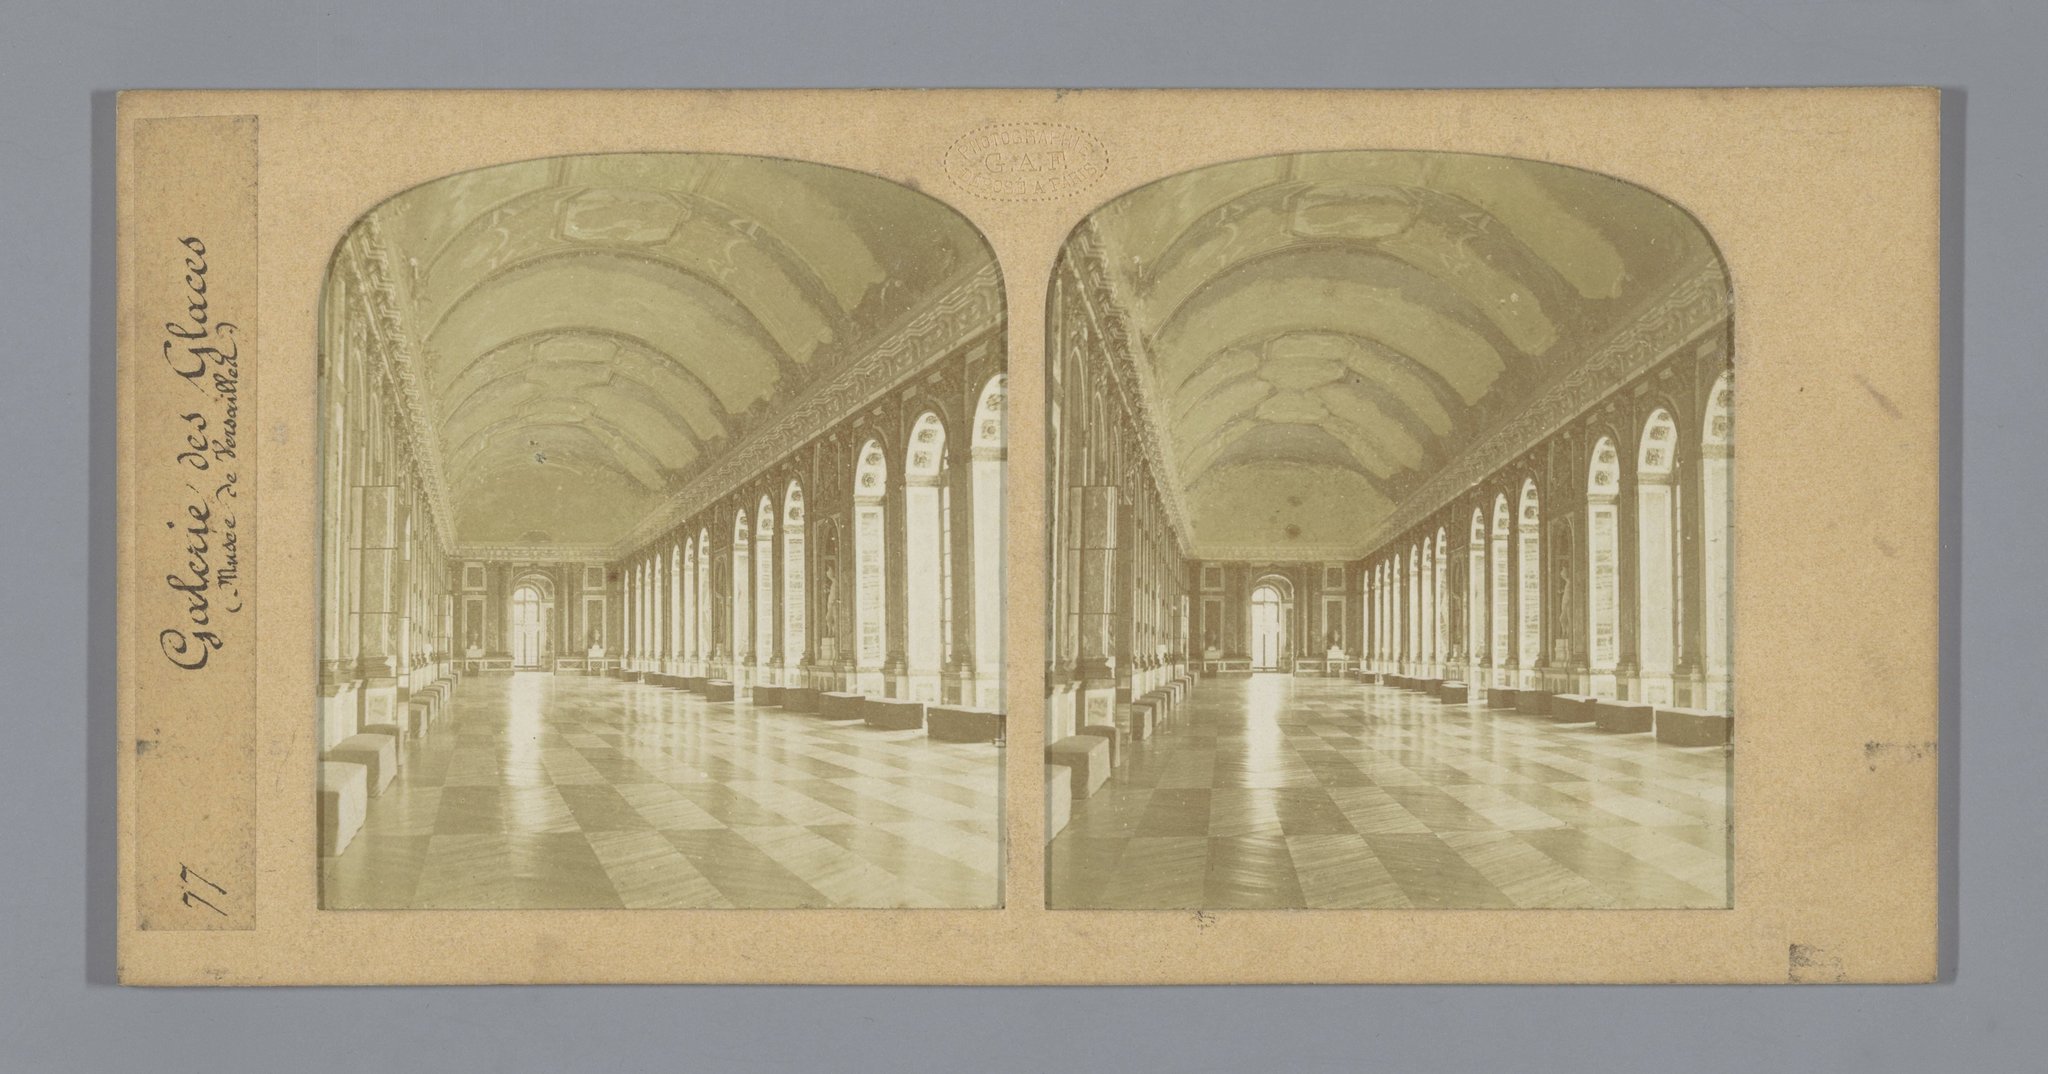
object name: tissue stereograph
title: Interieur van de Spiegelzaal in het paleis van Versailles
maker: florent grau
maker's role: manufacturer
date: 1858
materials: cardboard, paper, photographic support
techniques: albumen print, hand coloring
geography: versailles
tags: interior ~ representation of a building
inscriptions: check stamp: ‘PHOTOGRAPHIE/ G.A.F./ DÉPOSÉ A PARIS’, inscription: ‘A LA COLONNADE DU LOUVRE./ H. GUÉRARD/ 156, rue de Rivoli, PARIS./ VUES STÉRÉOSCOPIQUES DE TOUS PAYS/ FABRIQUE DE STÉRÉOSCOPES.’, number: ‘77’